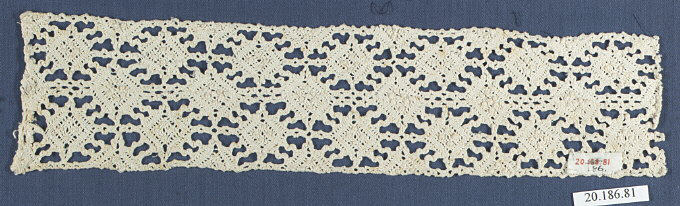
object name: insertion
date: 1501-1600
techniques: lace